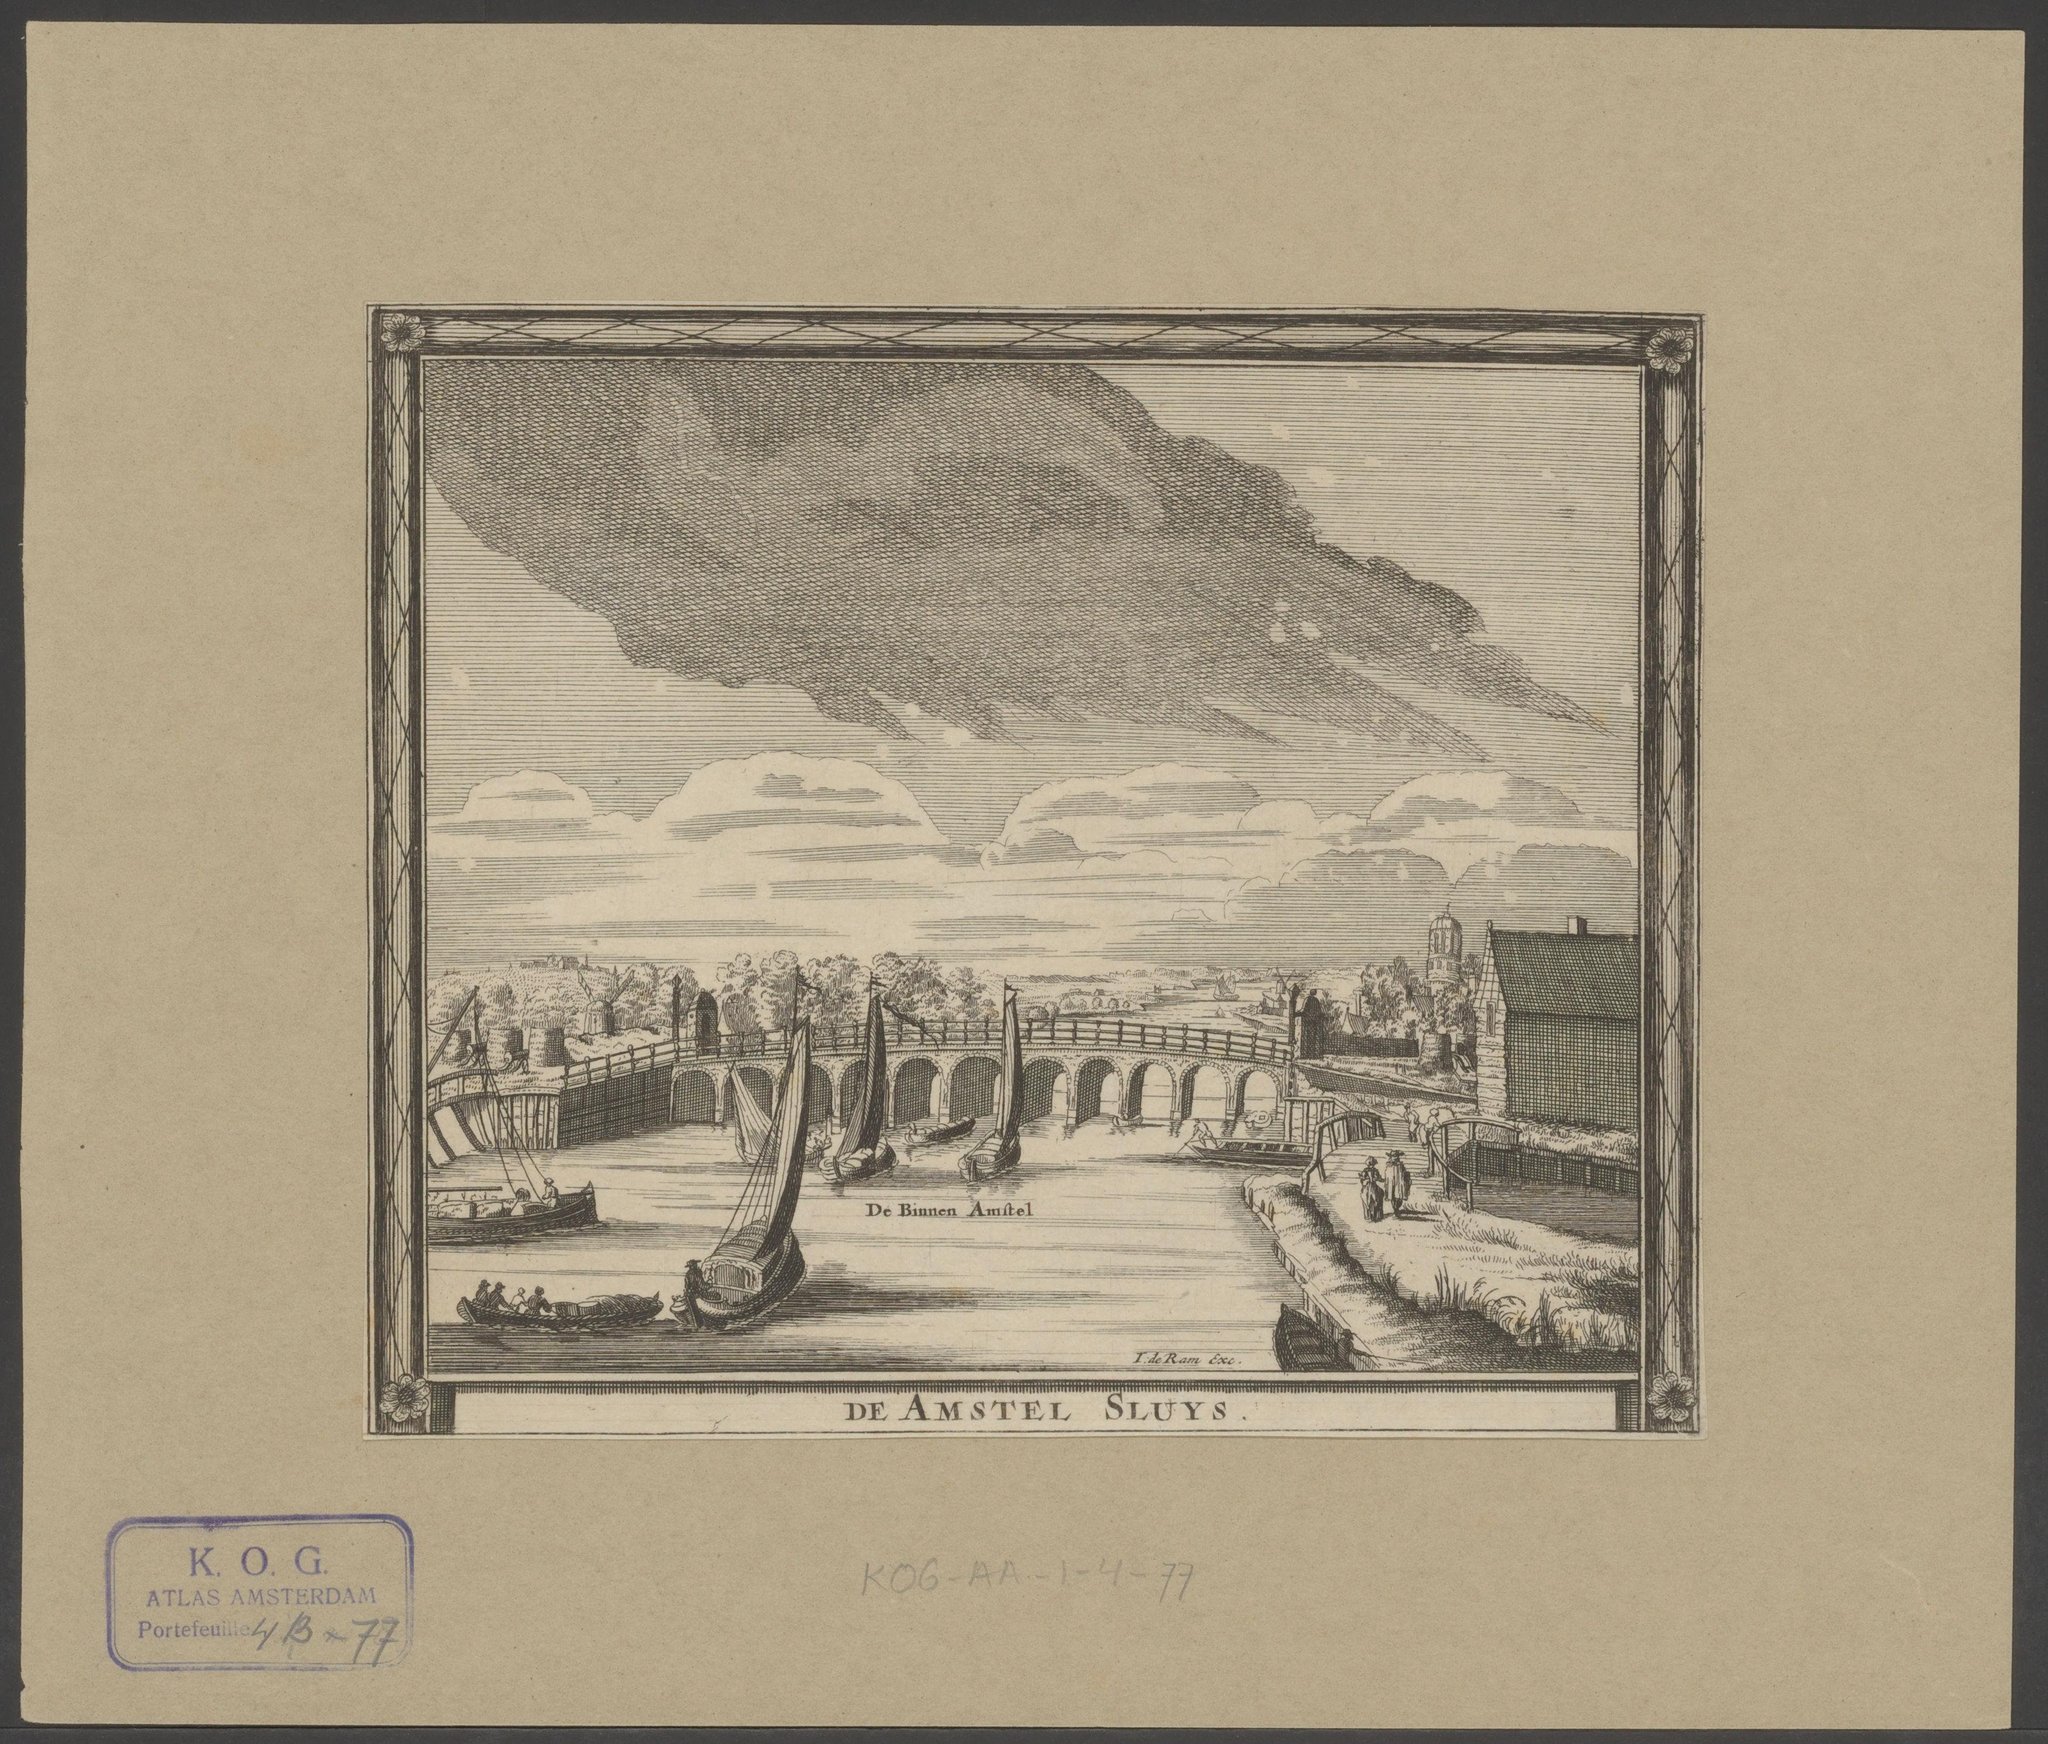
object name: print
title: Gezicht op de Binnen-Amstel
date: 1668-1693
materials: paper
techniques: etching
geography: amsterdam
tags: sluice, weir, sailing-ship, sailing-boat, city-view in general; 'veduta', canal, bridge in city across river, canal, etc.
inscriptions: collector's mark: ‘4B-77’ Lugt 1641b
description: Onderwerpsrubriek binnen de Atlas Amsterdam: Amstel van Blauwbrug tot Hogesluis.